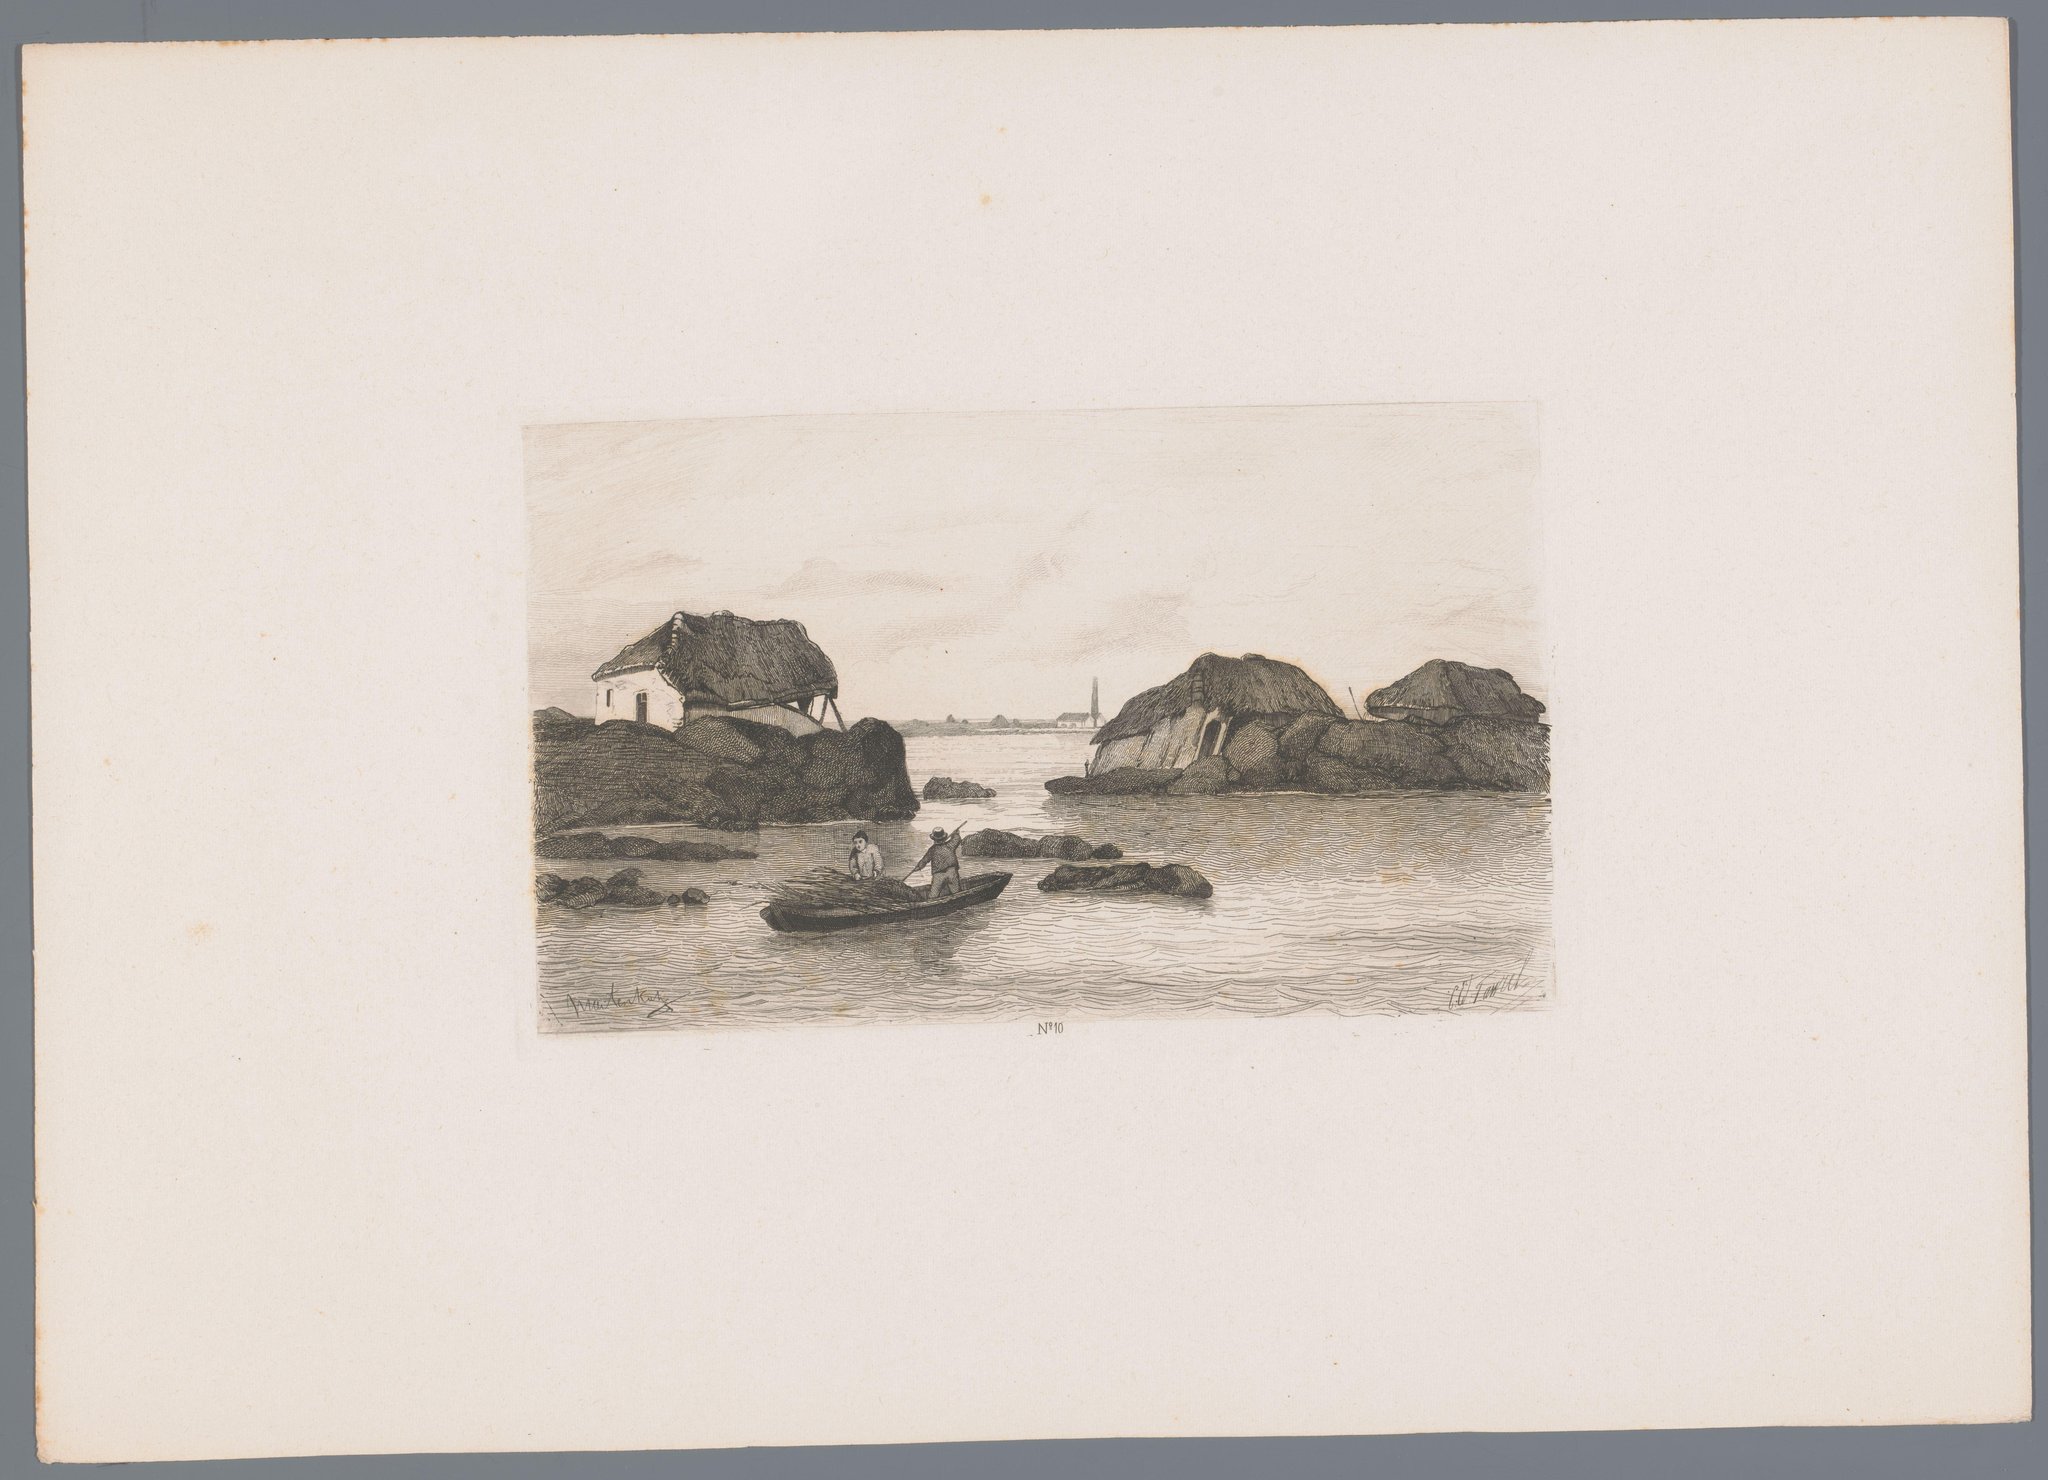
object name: print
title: De Waterramp van 1855. Geschetst in 24 afbeeldingen, naar de natuur geteekend en geëtst door leden der Maatschappij Arti et Amicitiae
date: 1855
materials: paper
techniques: etching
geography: netherlands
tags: flood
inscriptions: collector's mark: Lugt 2228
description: Gezicht op het onder water staande dorp Dreumel, in de verte het stoomgemaal, 8 maart 1855. Onderdeel van de reeks van 24 prenten over de watersnood van maart 1855, door leden van het genootschap Arti et Amicitiae. Uitgave ten behoeve van de slachtoffers van de watersnood.